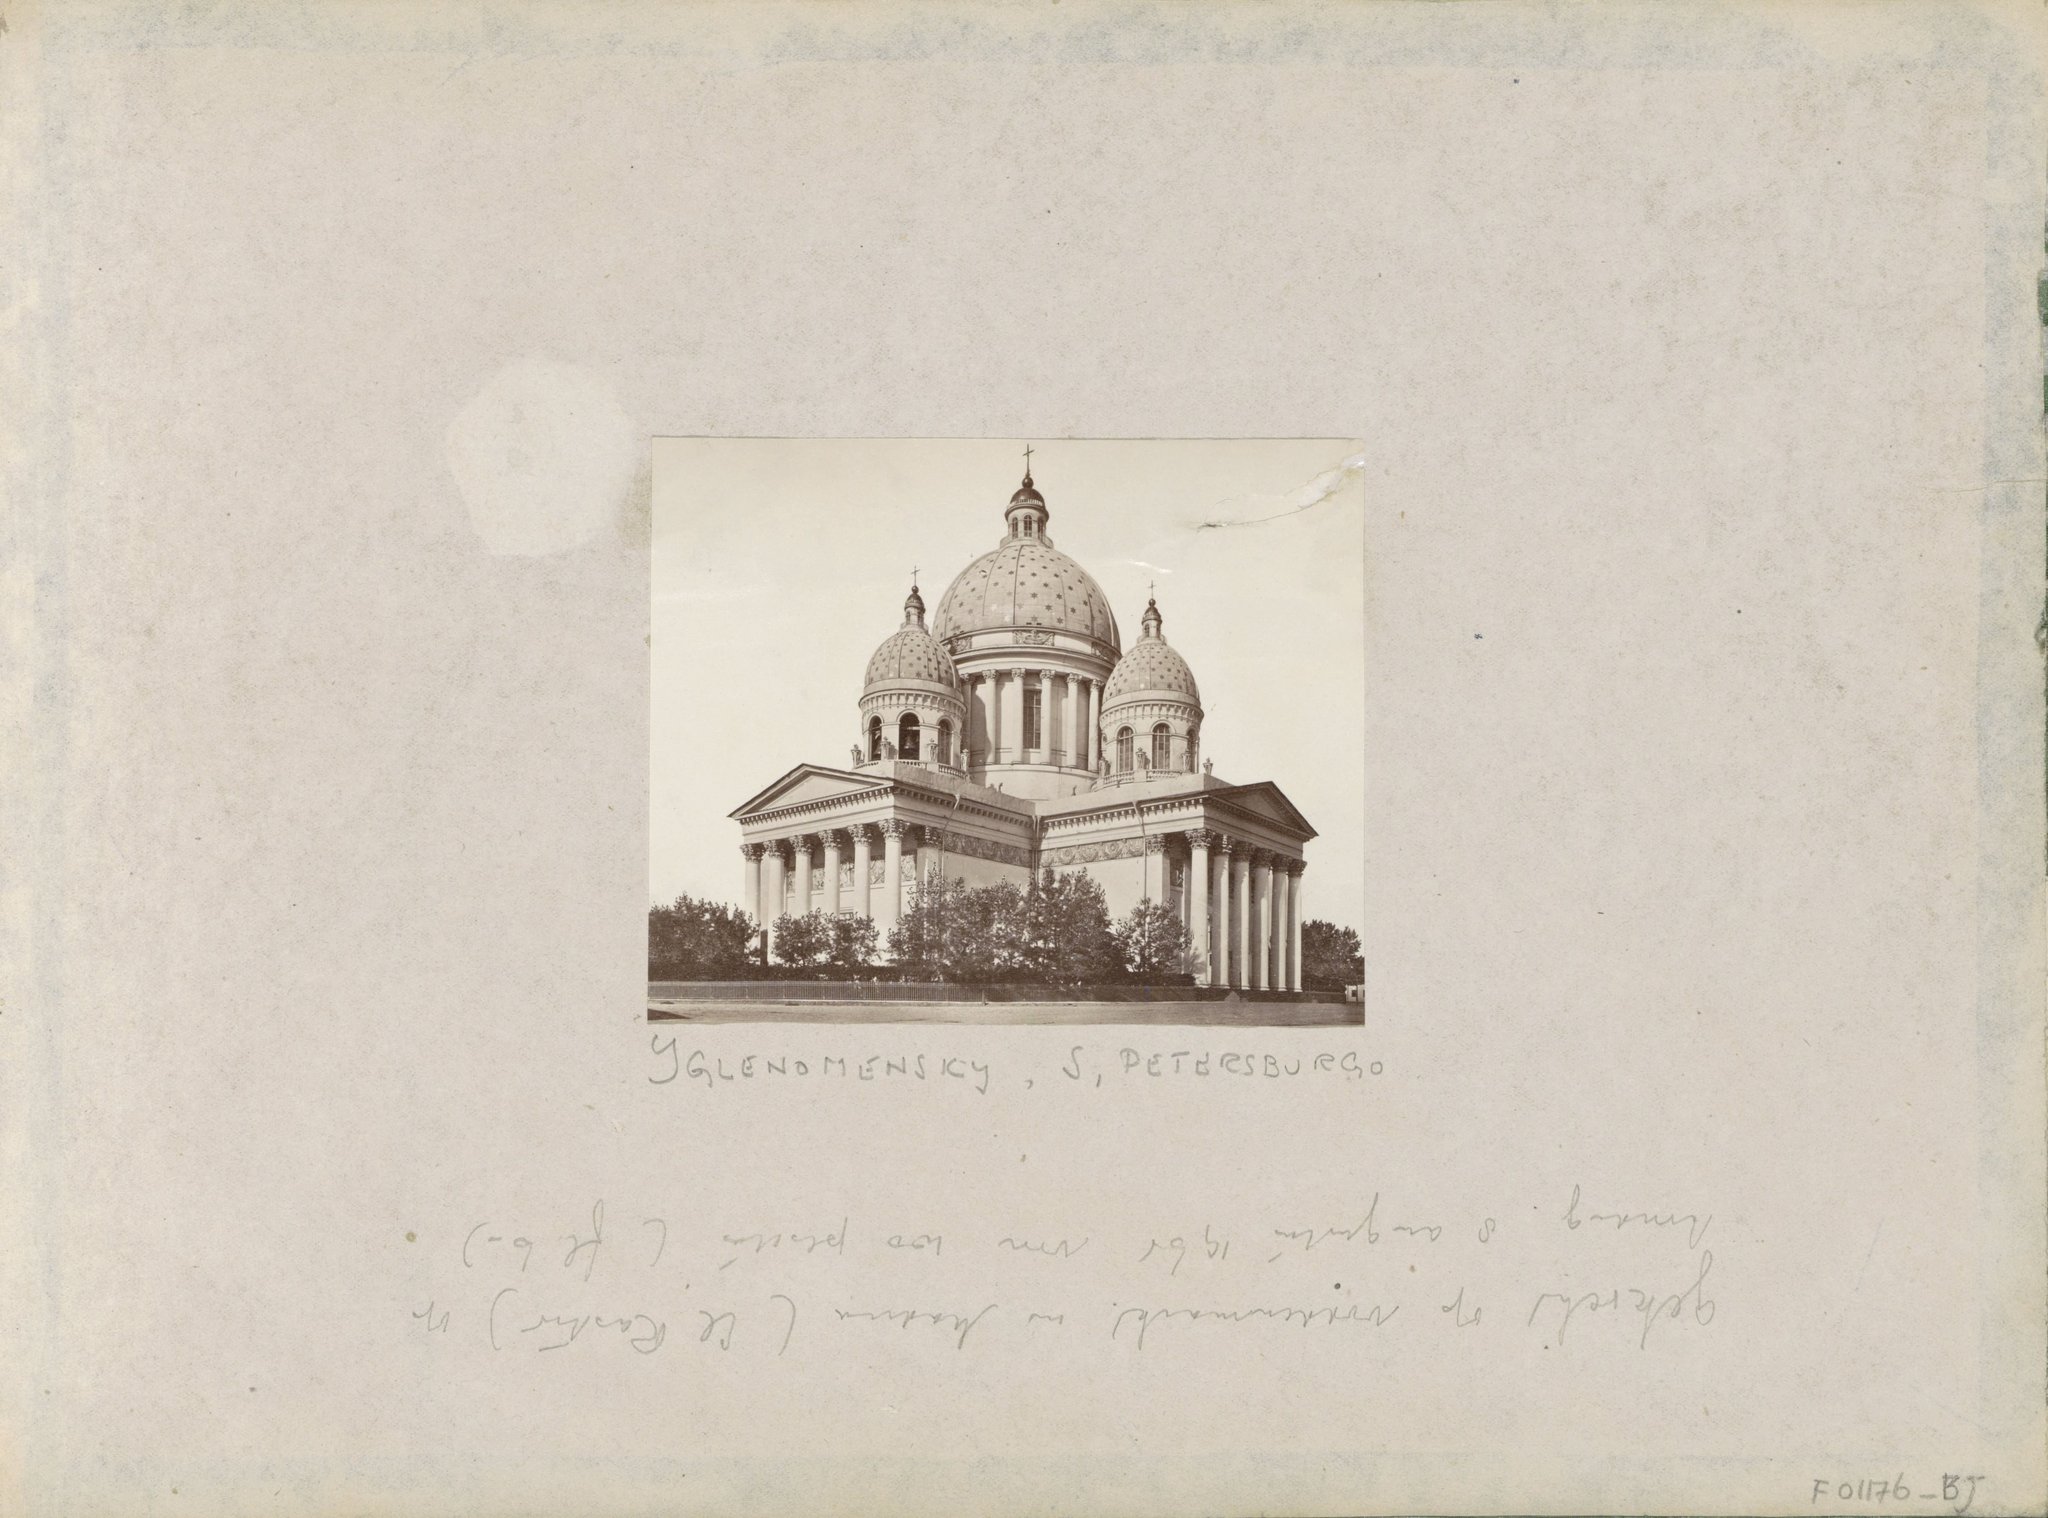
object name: photograph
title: Exterieur van de Izaäkkathedraal in Sint Petersburg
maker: alfred lorens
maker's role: fotograaf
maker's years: 1830-1896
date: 1850-1876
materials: photographic support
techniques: albumen print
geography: sint-petersburg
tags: russian orthodox church, travelling; tourism, dome ~ architecture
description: Onderdeel van Reisalbum met foto's en tekeningen van Manuel Mayo 1876.